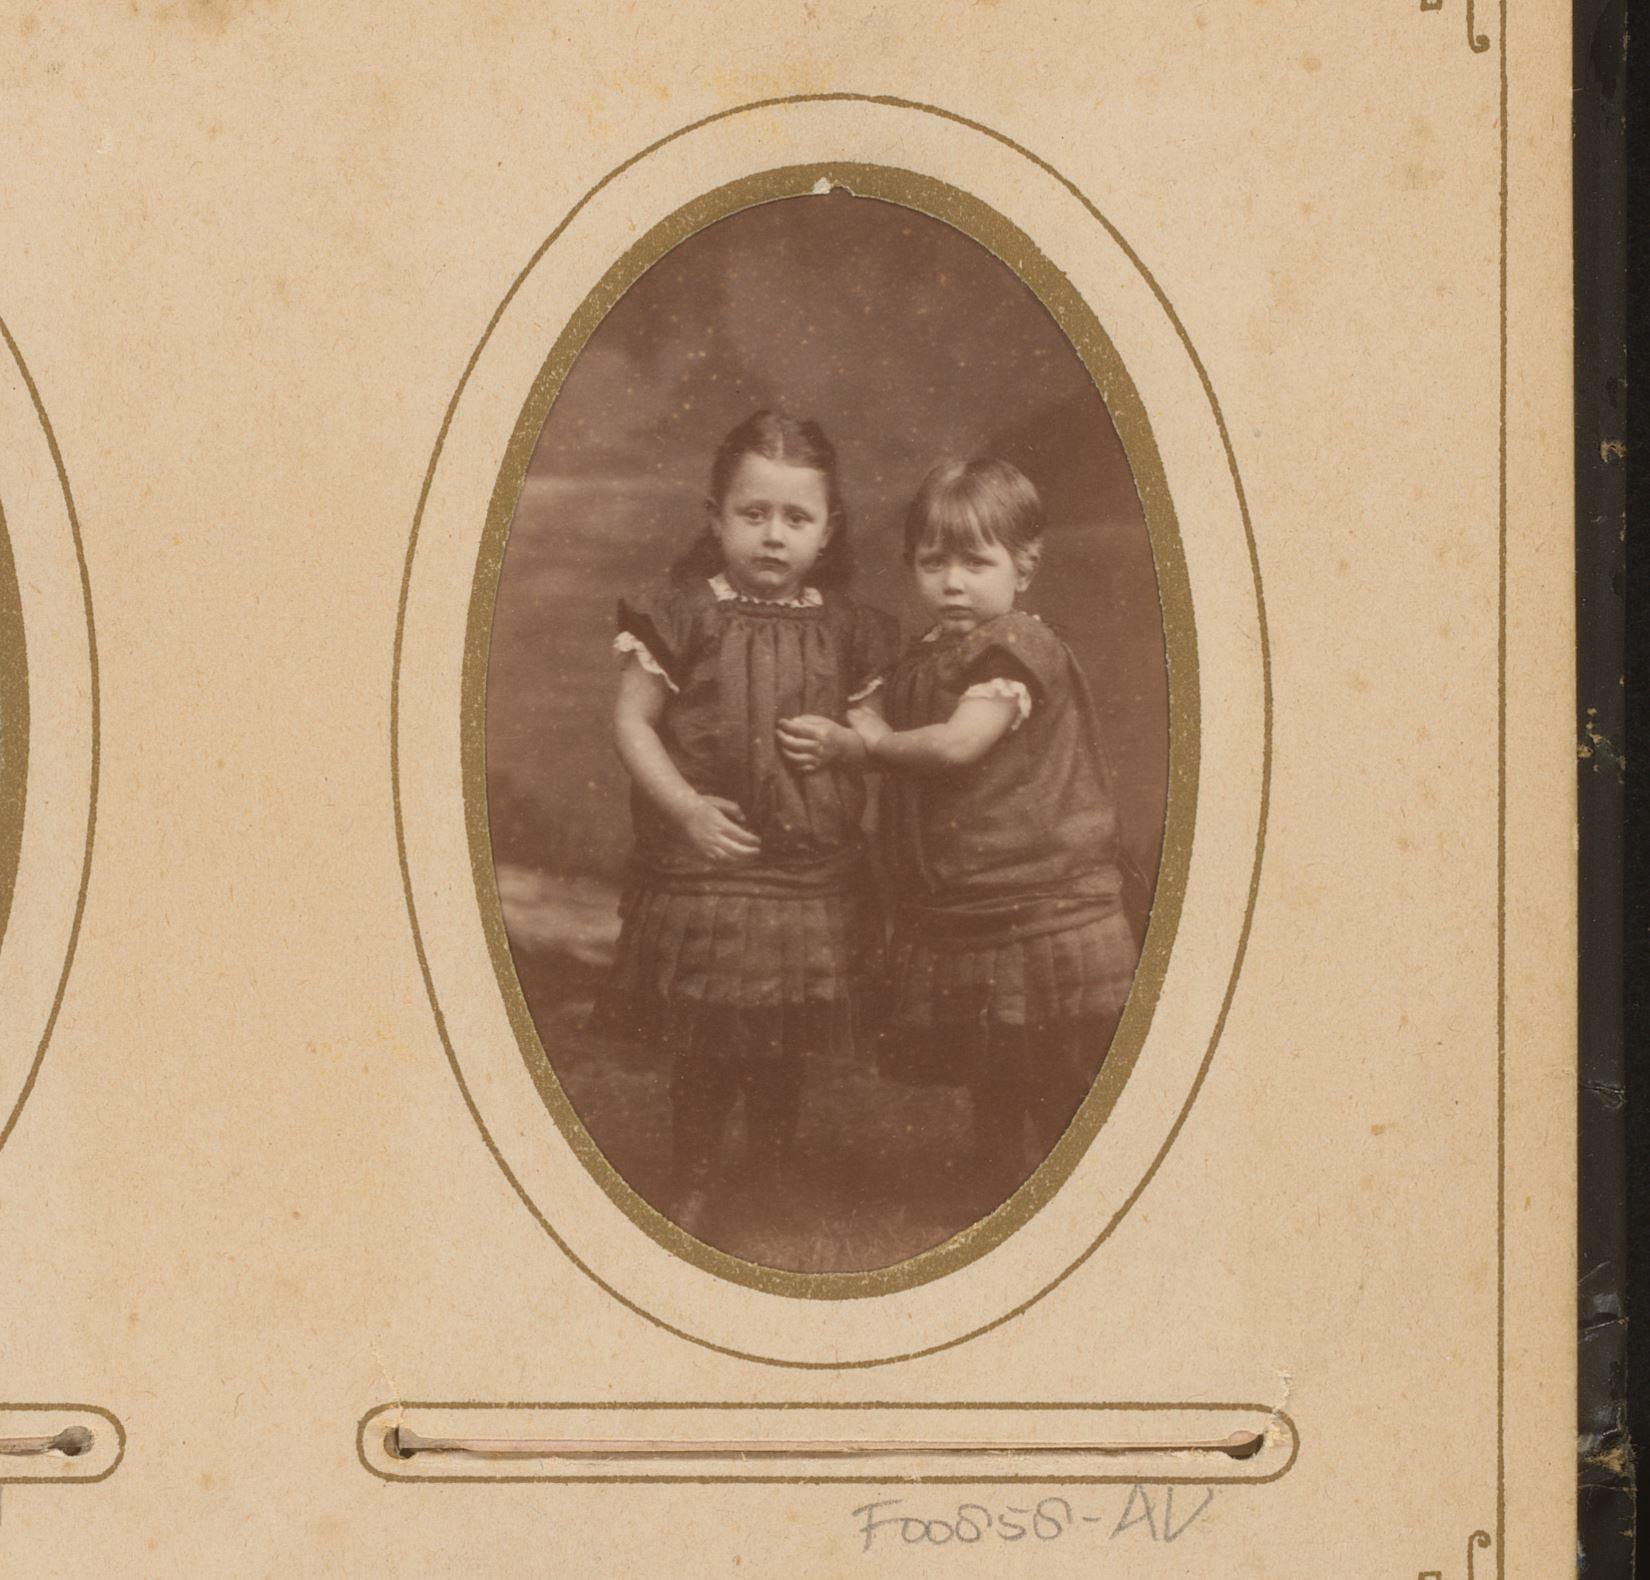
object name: album leaf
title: Portret van twee meisjes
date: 1884-1895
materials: cardboard, photographic support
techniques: albumen print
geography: north holland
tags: girl (child between toddler and youth)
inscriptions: inscription: ‘Alkmaar, Verdronken Oord; Nieuwediep, Kanaalweg tegenover Tivoli’